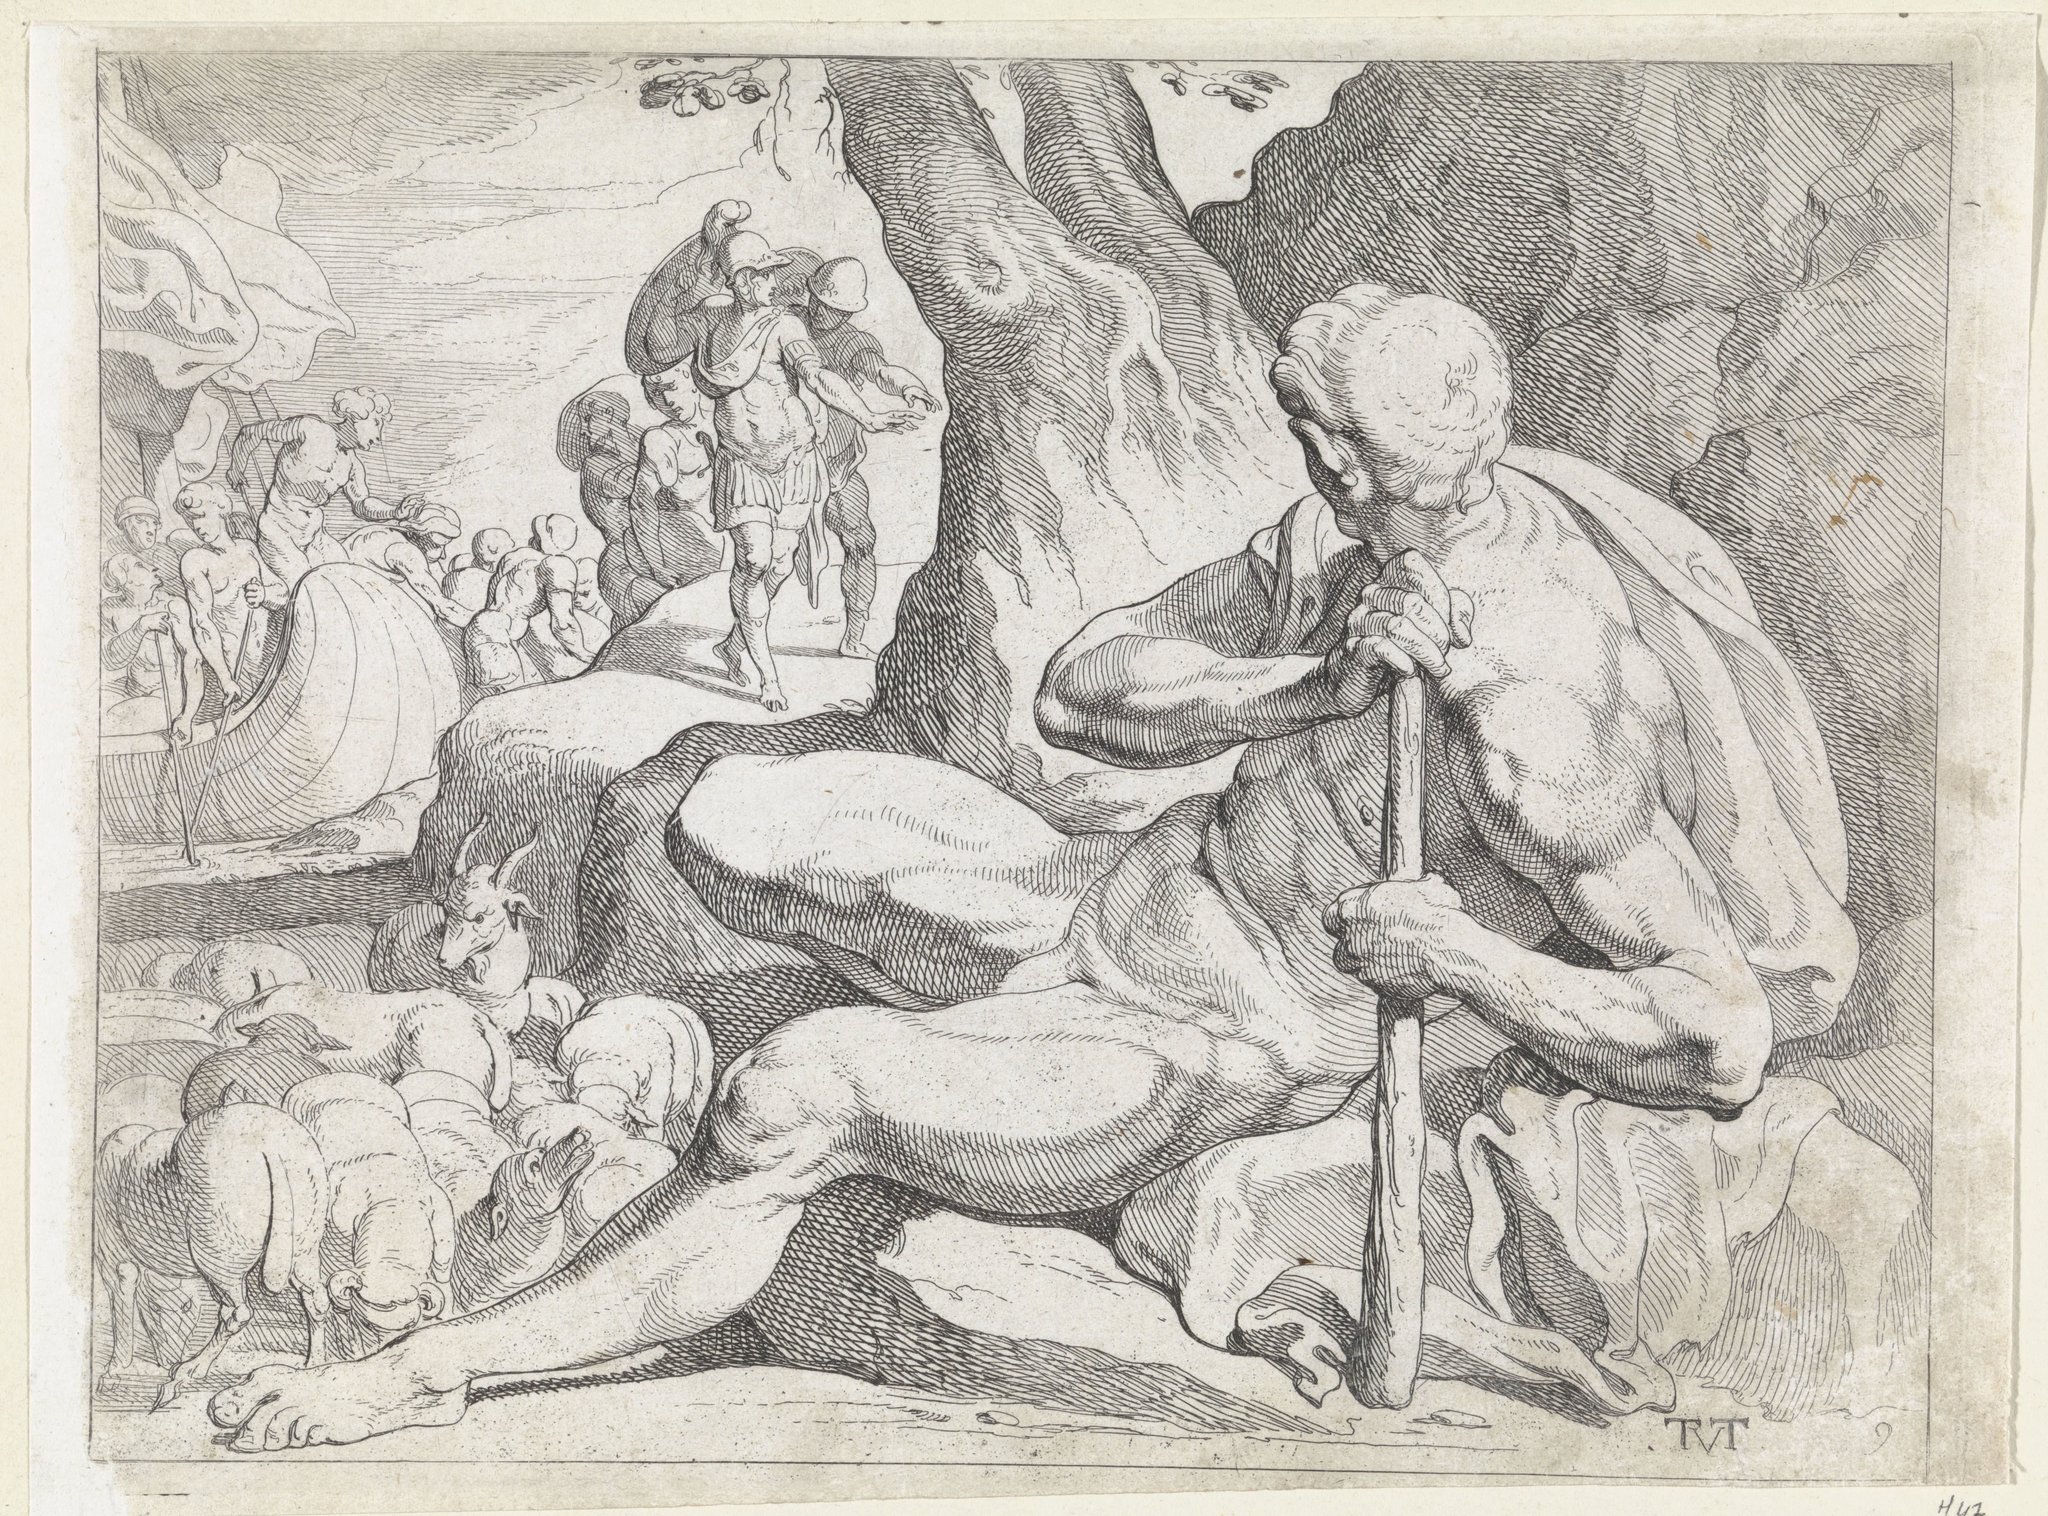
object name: print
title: De werken van Odysseus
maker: theodoor van thulden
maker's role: draughtsman, painter, print maker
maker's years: 1606-1669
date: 1632-1633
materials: paper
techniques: engraving, etching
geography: paris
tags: ulysses and his companions in the land of the cyclopes (homer, odyssey ix), polyphemus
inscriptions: collector's mark: Lugt 2228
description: De reus Polyphemus bewaakt de kudde en ziet hoe Odysseus en zijn mannen aan land gaan.